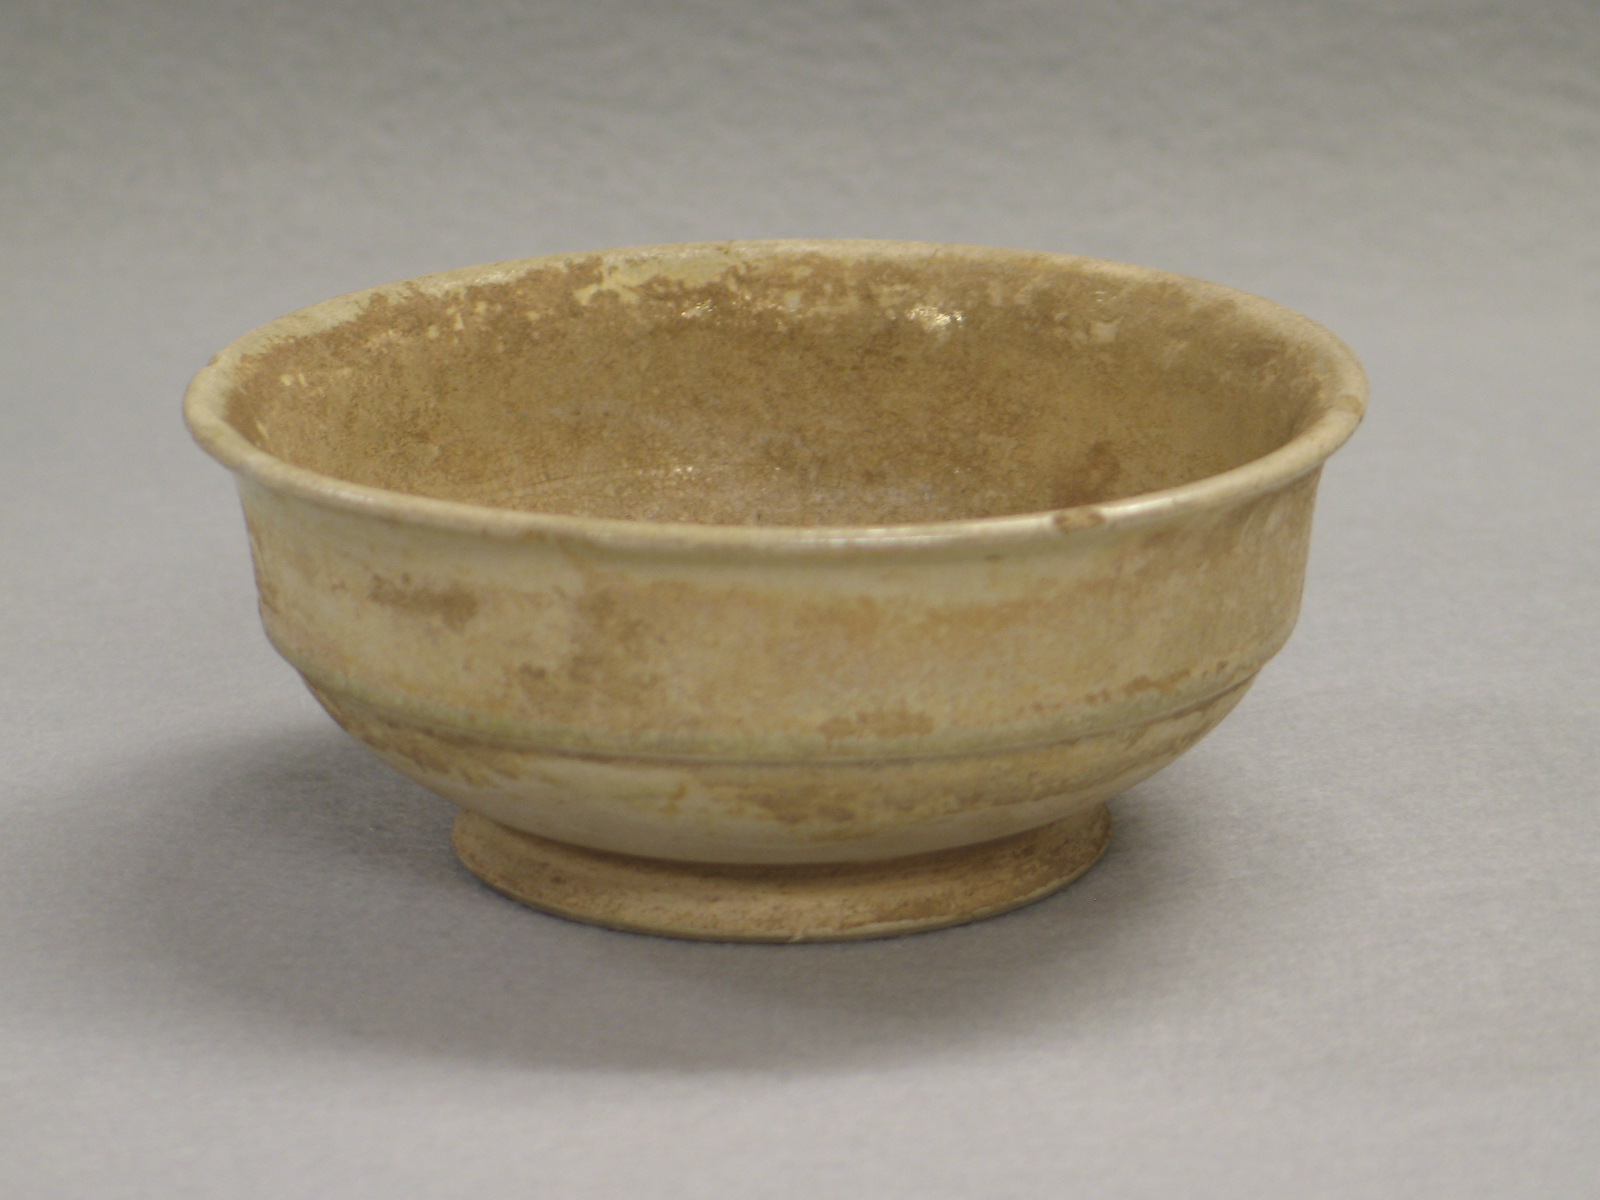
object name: bowl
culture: chinese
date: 618-907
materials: earthenware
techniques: glazing